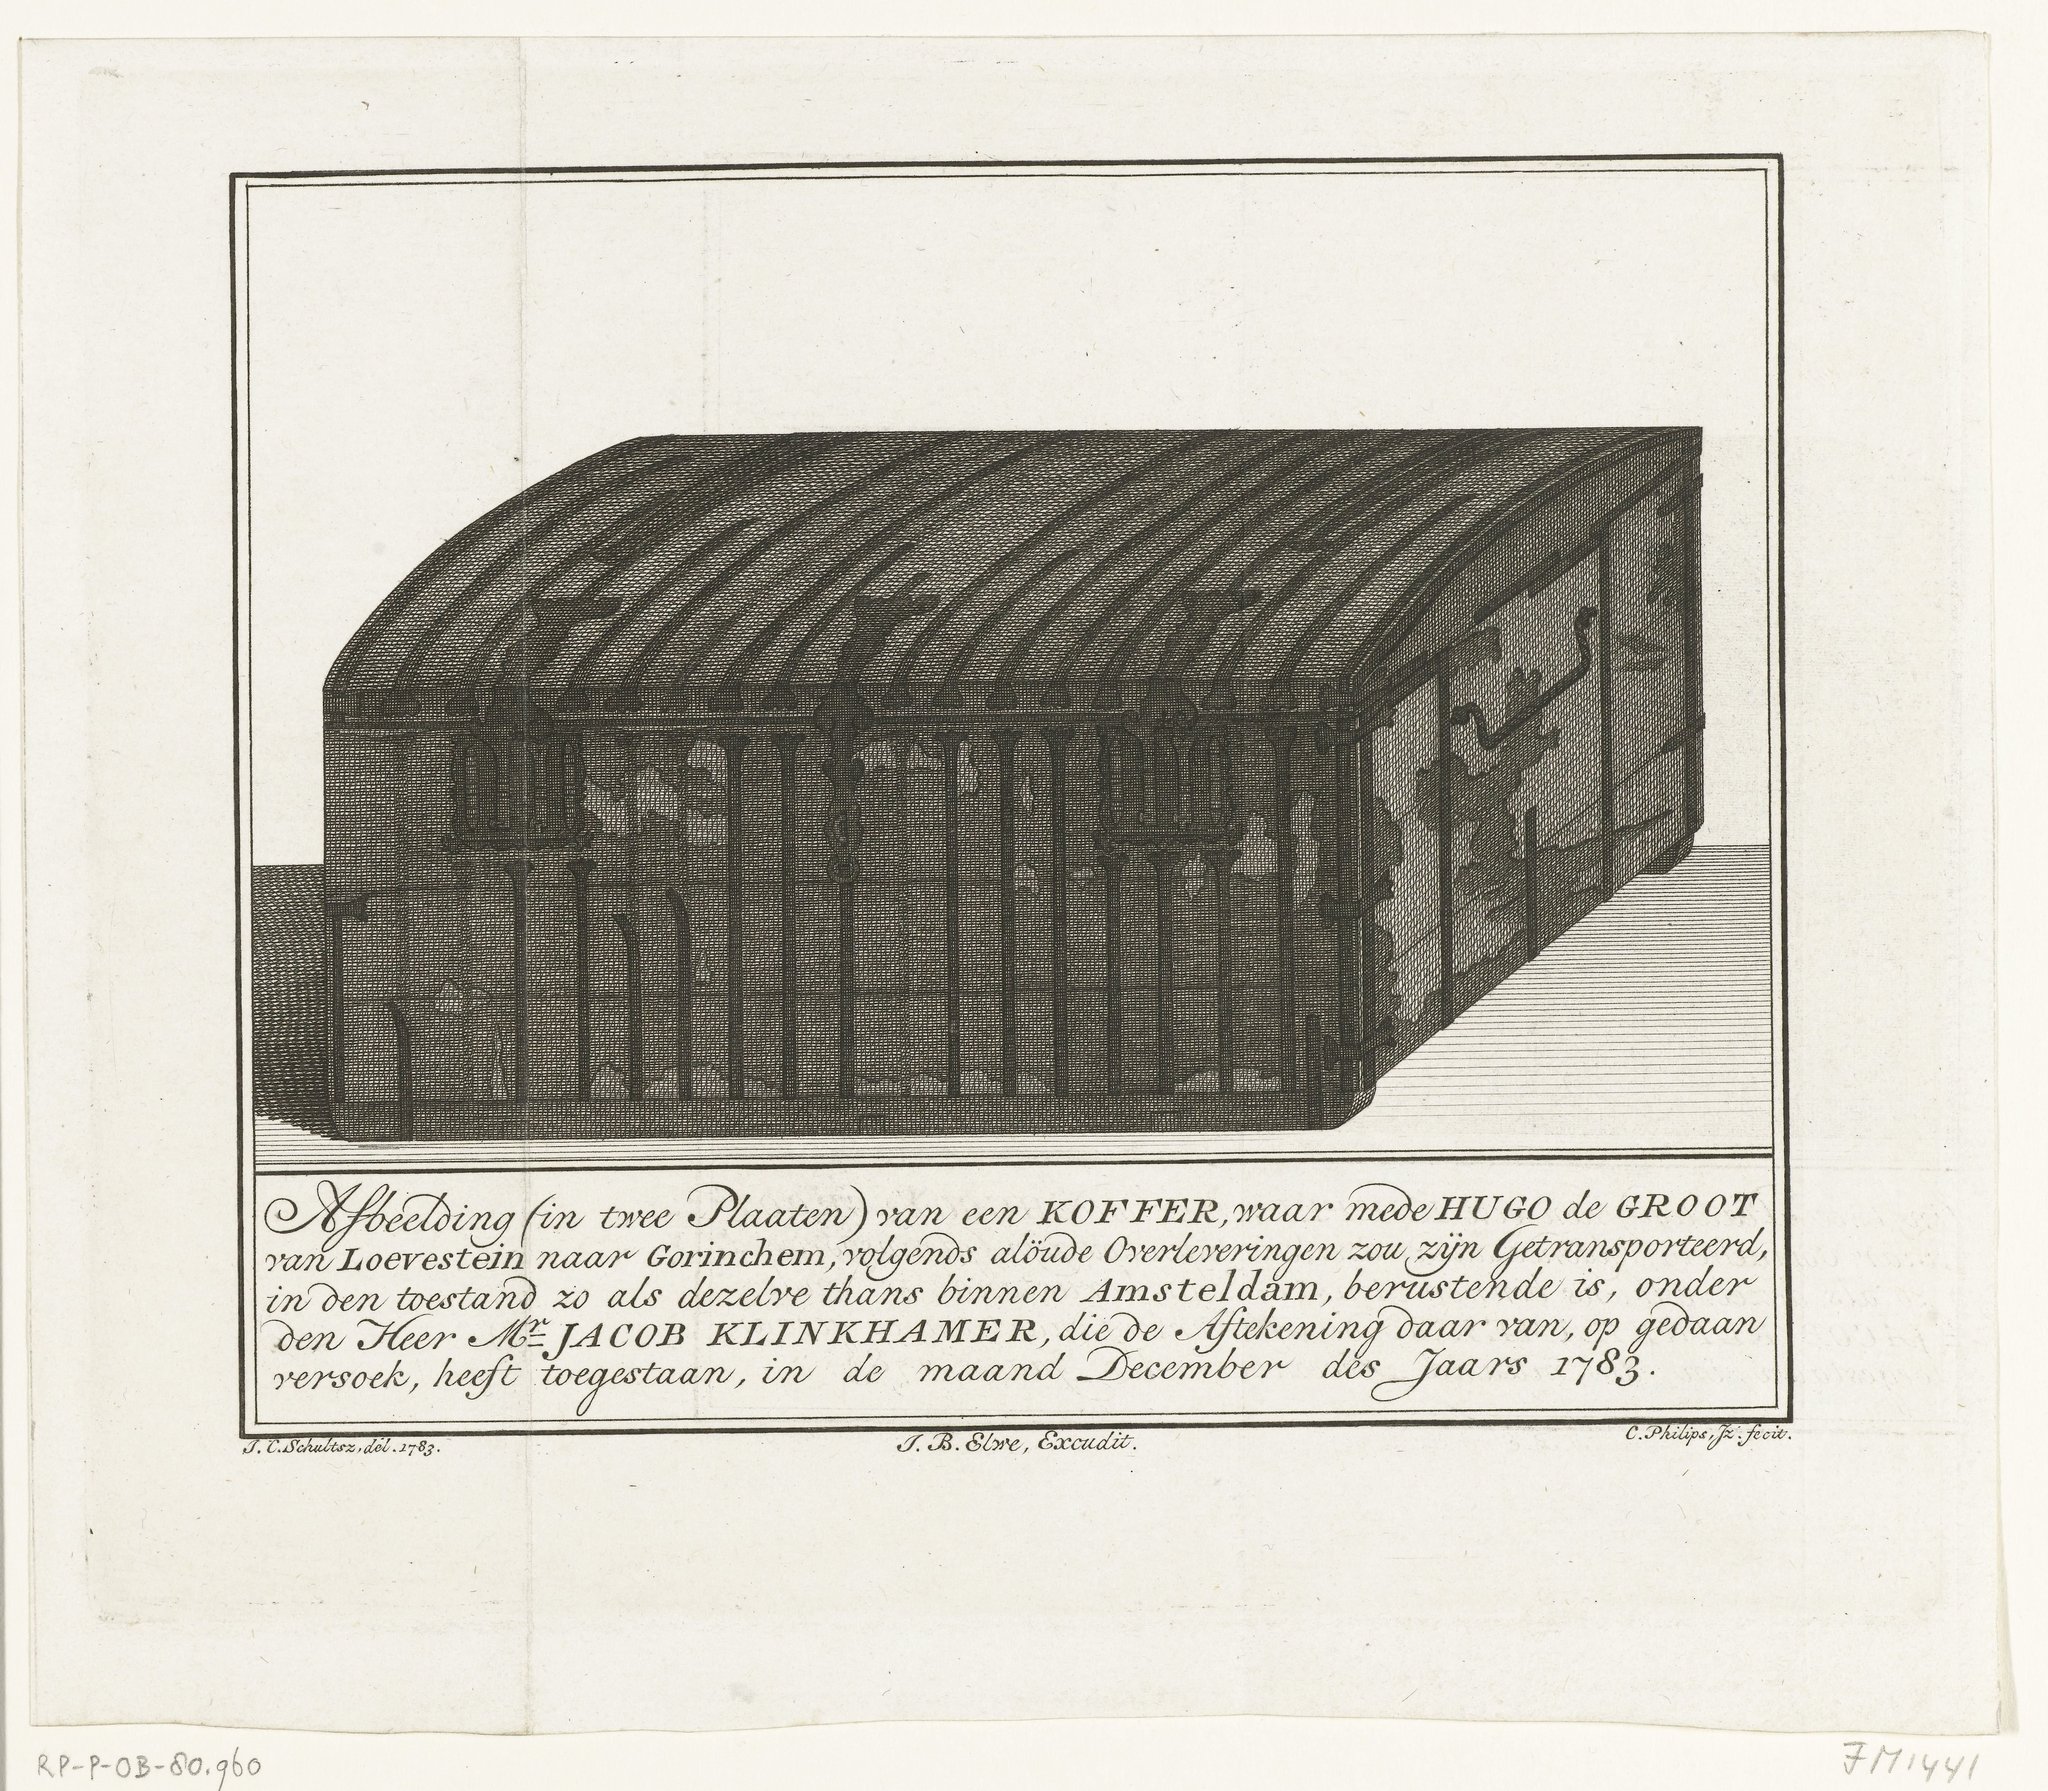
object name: print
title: Afbeelding (in twee Plaaten) van een Koffer, waar mede Hugo de Groot van Loevestein naar Gorinchem, volgens alöude Overleveringen zou zijn Getransporteerd, in den toestand zo als dezelve thans binnen Amsteldam, berustende is, onder den Heer Mr. Jacob Klinkhamer, die de Aftekening daar van, op gedaan versoek, heeft toegestaan, in de maand December des Jaars 1783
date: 1783-1785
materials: paper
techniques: etching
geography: netherlands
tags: delft, hugo de groot, trunk, suit-case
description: Volgens het bericht van de uitgever in deze vorm vervaardigd om toe te kunnen voegen aan Jan Wagenaar, Vaderlandsche historie, dl. X en in andere werken. Ook gebruikt als illustratie in: J. Klinkhamer, Het leven van Hugo de Groot : getrokken uit de voornaamste historieschryvers en dichters; doormengd met onpartydige aanmerkingen, en versierd met twee juiste afbeeldingen van het koffer, waarin De Groot zyne gevangenis ontkomen is: getekend naar het echte koffer zelf, thans berustende onder den heer, Mr. Jacob Klinkhamer, J.B. Elwe en D.M. Langeveld, Amsterdam 1785.